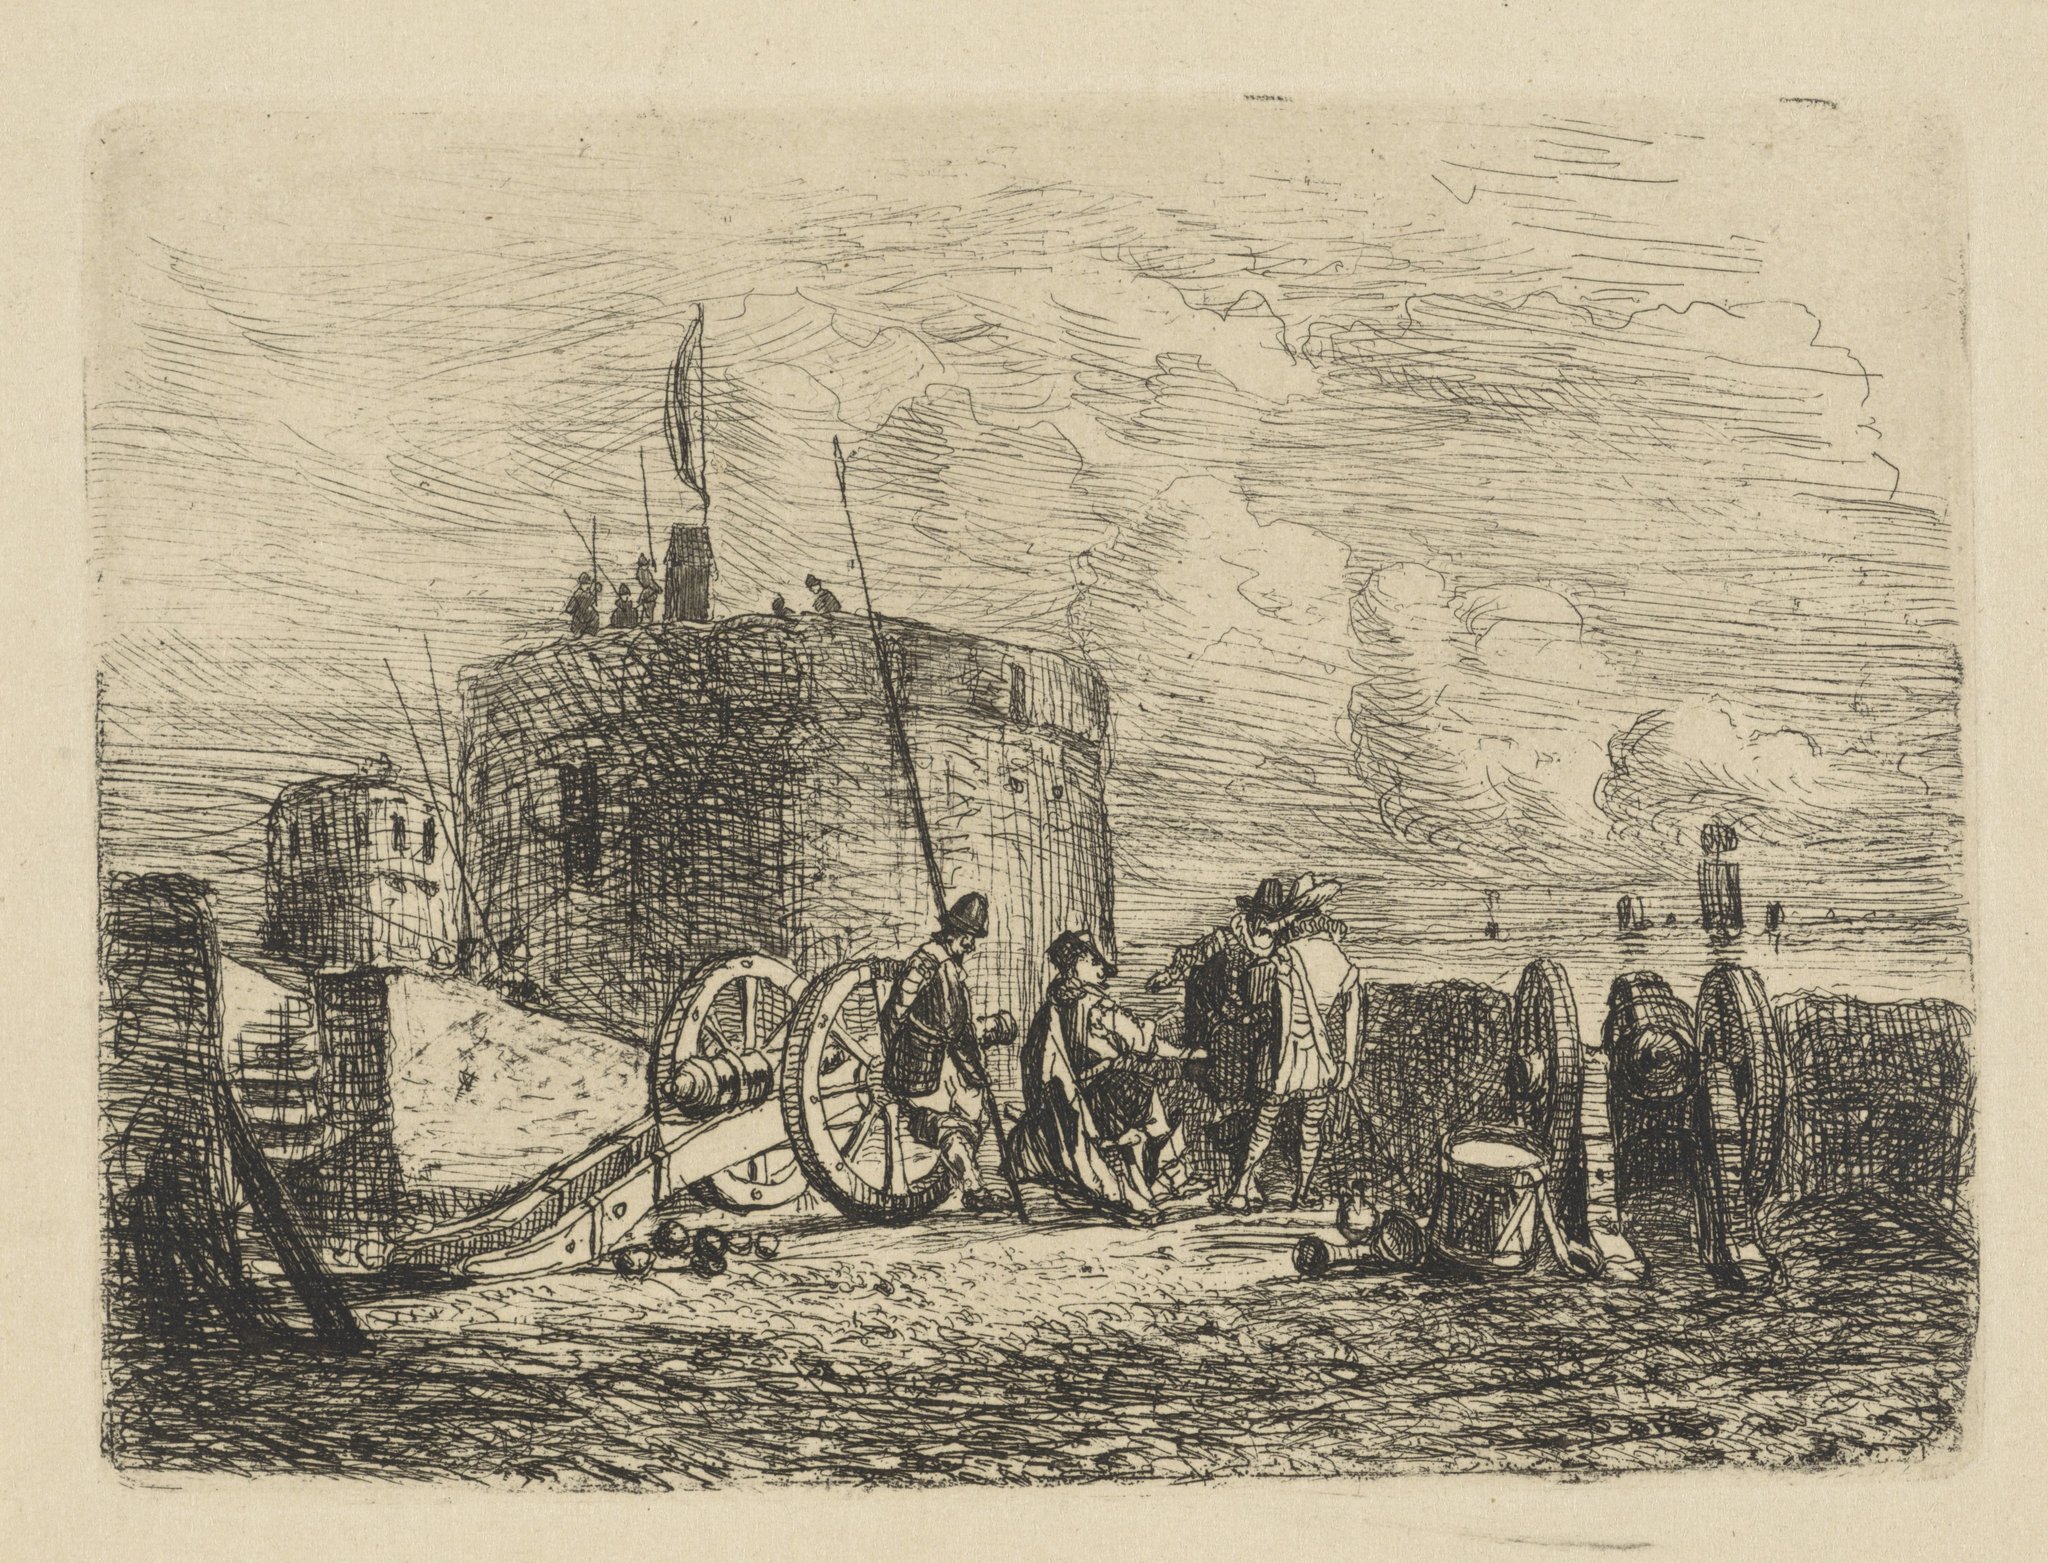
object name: print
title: Soldaten bij een kustbatterij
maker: henri adolphe schaep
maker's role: draughtsman, painter, print maker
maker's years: 1826-1870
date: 1841-1870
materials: paper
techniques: etching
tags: firearms: cannon, coast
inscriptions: collector's mark: Lugt 2228